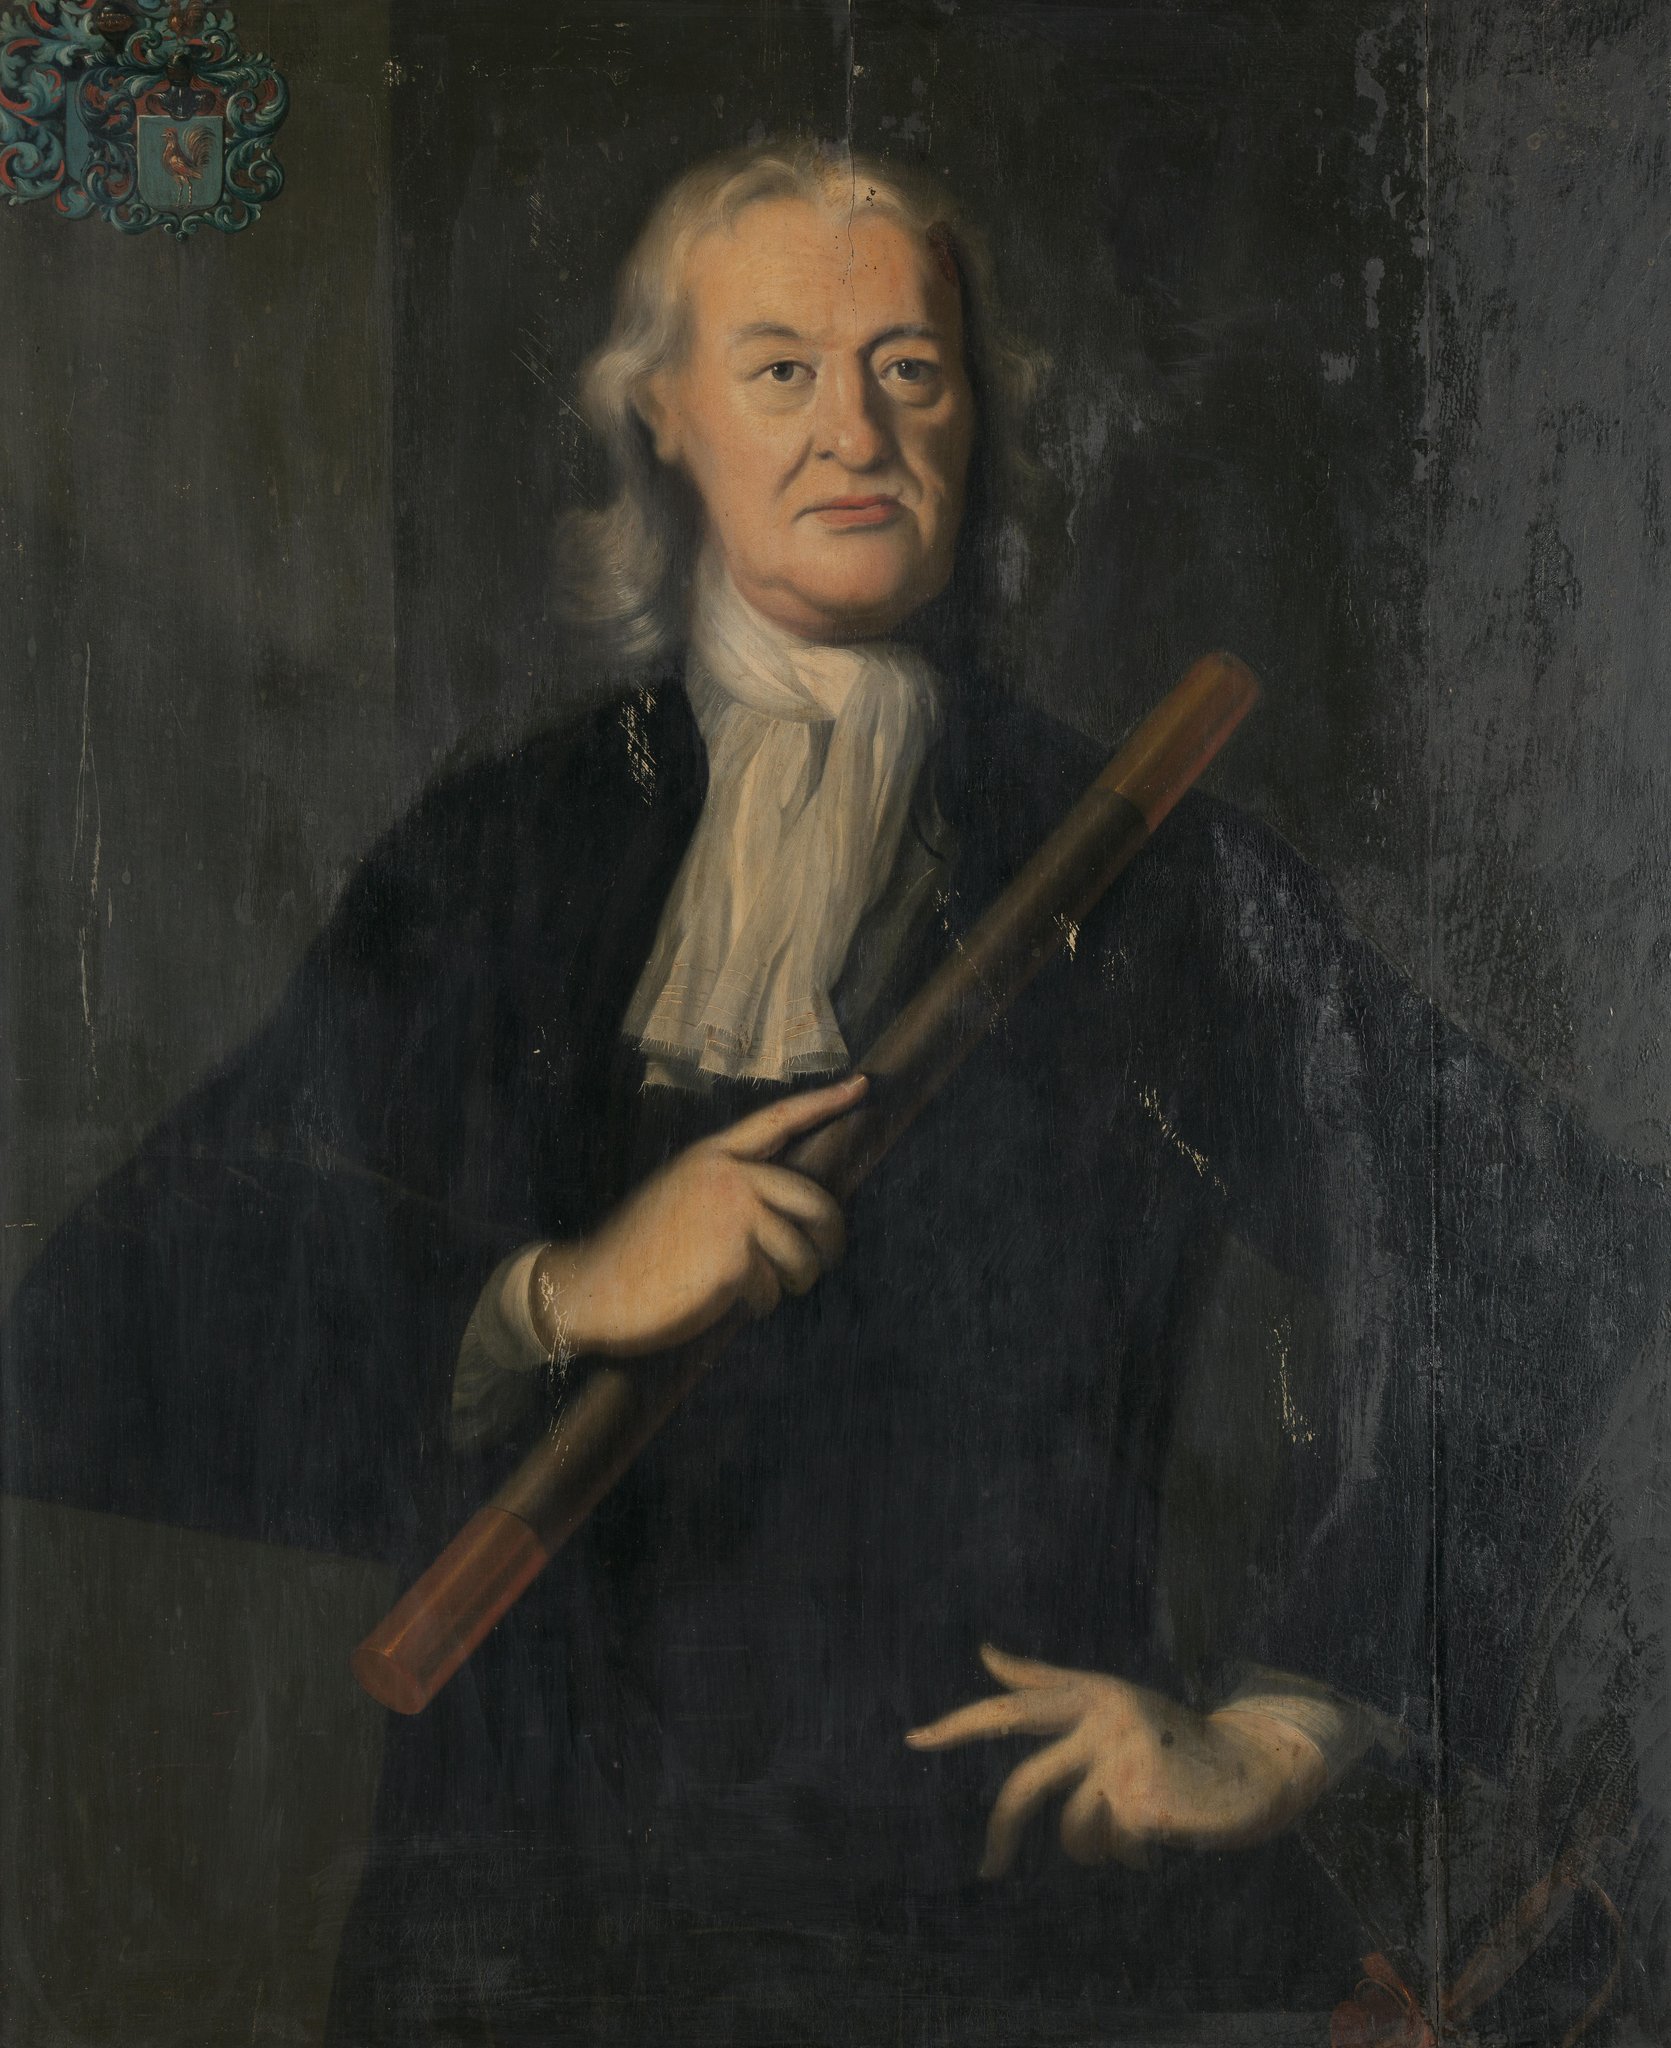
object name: painting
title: Mattheus de Haan (1725-1729)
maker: Anonymous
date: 1710-1726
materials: oil, panel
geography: batavia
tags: dordrecht, batavia, colonial governor, historical persons, baton of general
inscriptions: inscription and date: ‘Mattheus de Haan ...ern.r Generl. van Nederlands India October Aº 1726 AEtatis 63 Jaaren’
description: The highest-ranking Dutch East India Company (VOC) official in Asia was the governor-general. He presided in the Castle of Batavia (now Jakarta, Indonesia), a fort built by the Dutch. The assembly hall in the Castle of Batavia was the centre of Dutch power in Asia. The walls were hung with portraits of all of the governors-general. Most of the 18th-century examples shown here were painted in Asia, often by anony¬mous artists.